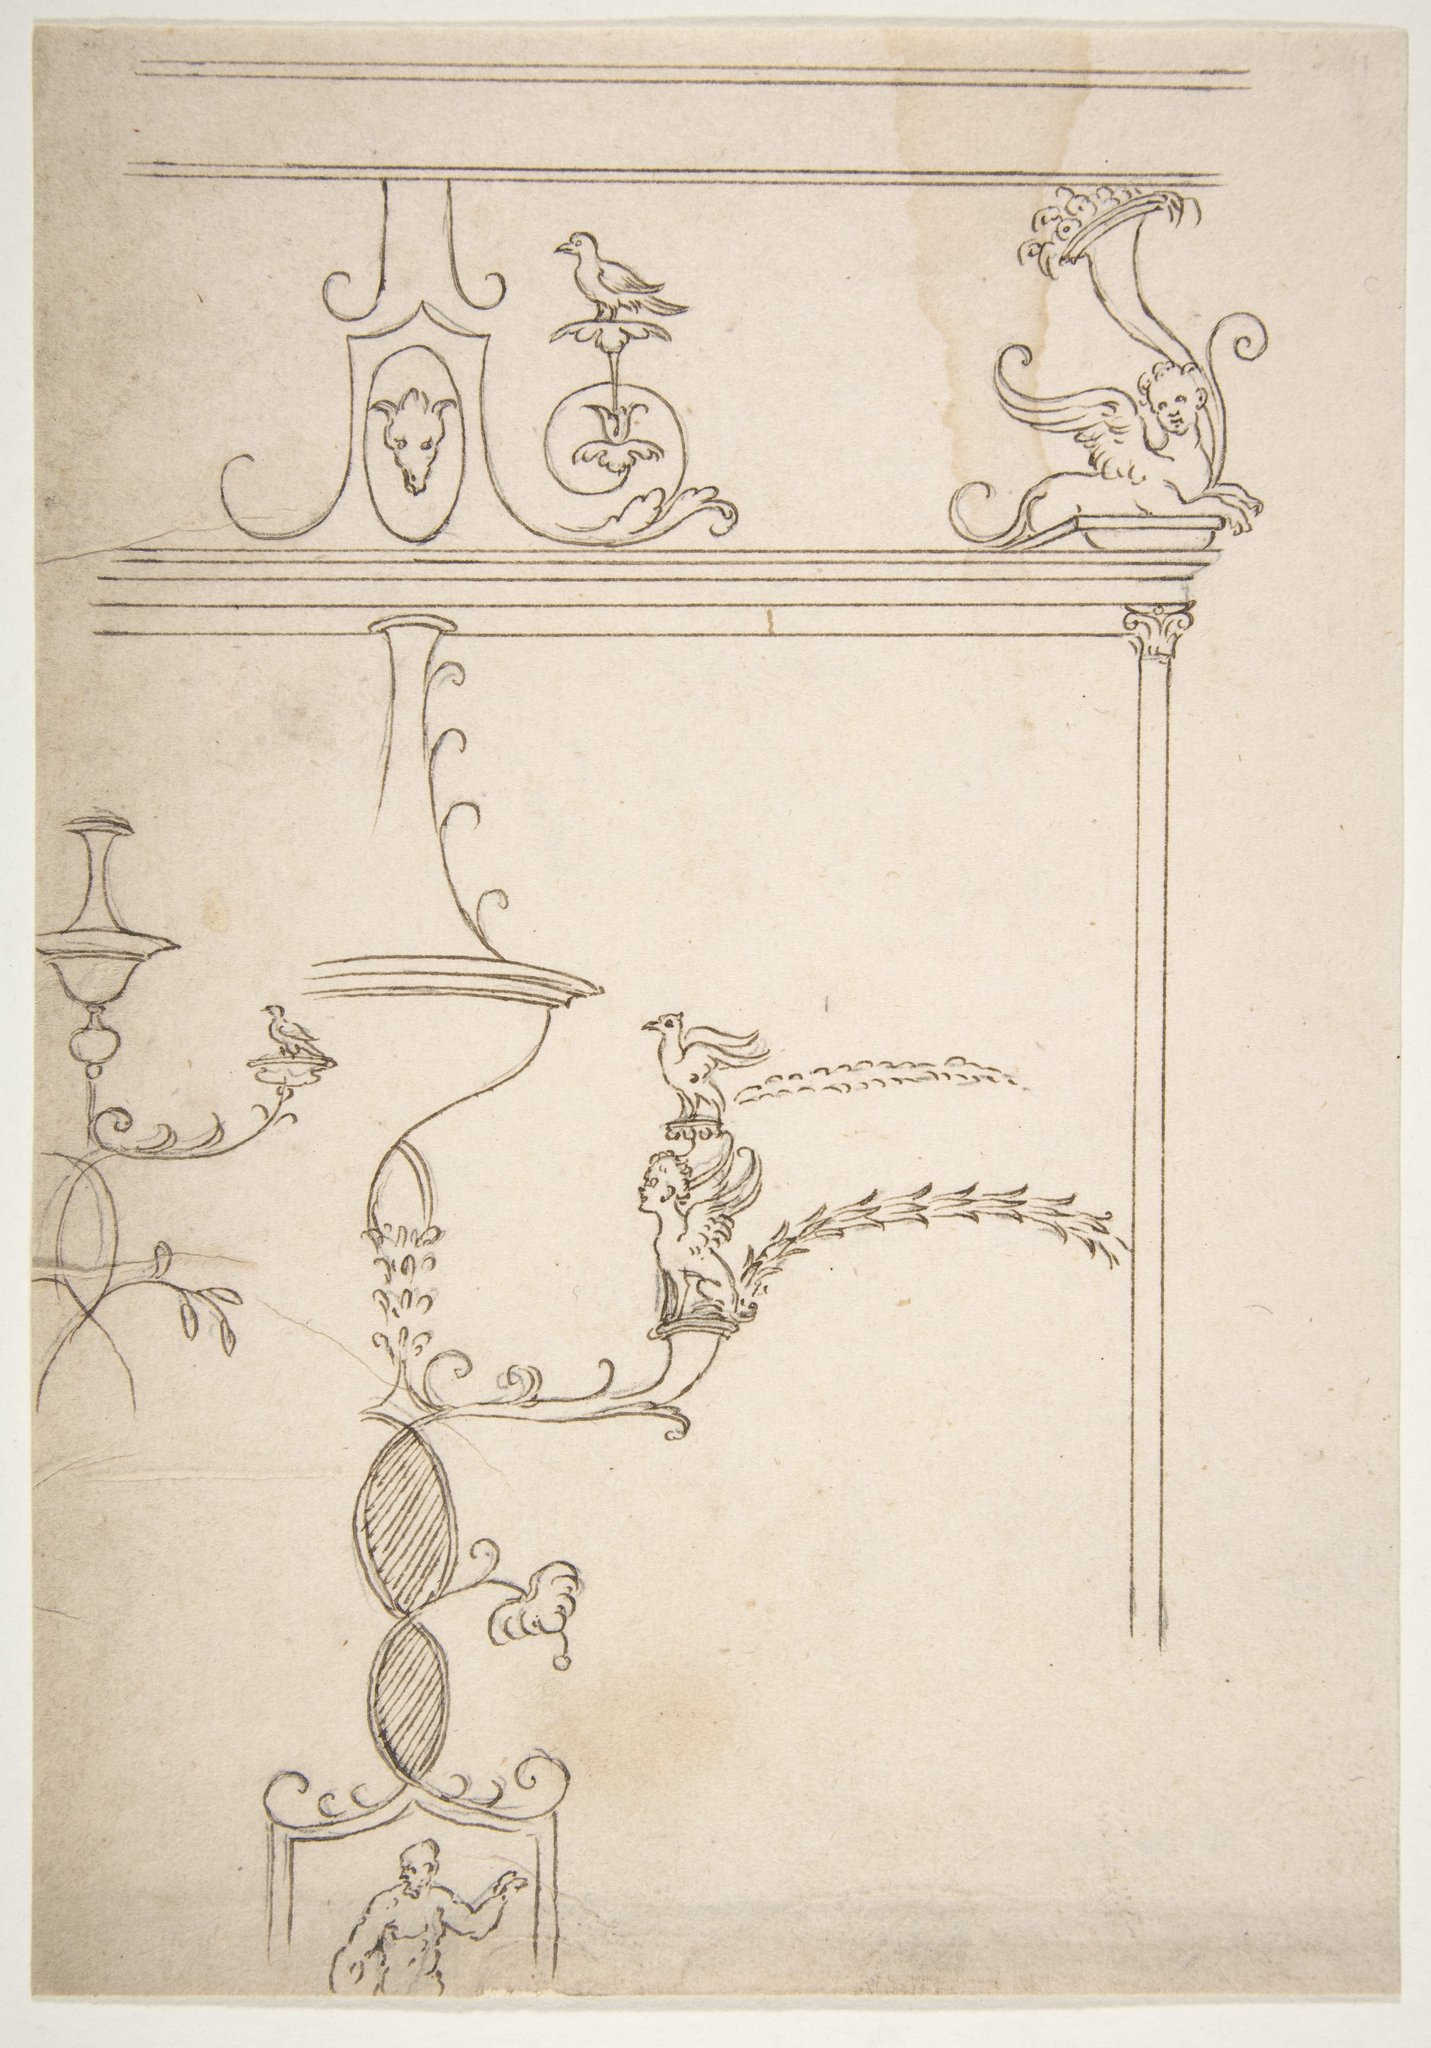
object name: collection ornament architecture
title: Domus Aurea, unidentified, grotteschi, details (recto) blank (verso)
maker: anonymous, french, 16th century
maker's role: draftsman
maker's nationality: french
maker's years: 1500-1600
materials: chalk, ink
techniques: incising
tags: birds,grotesques,ornament